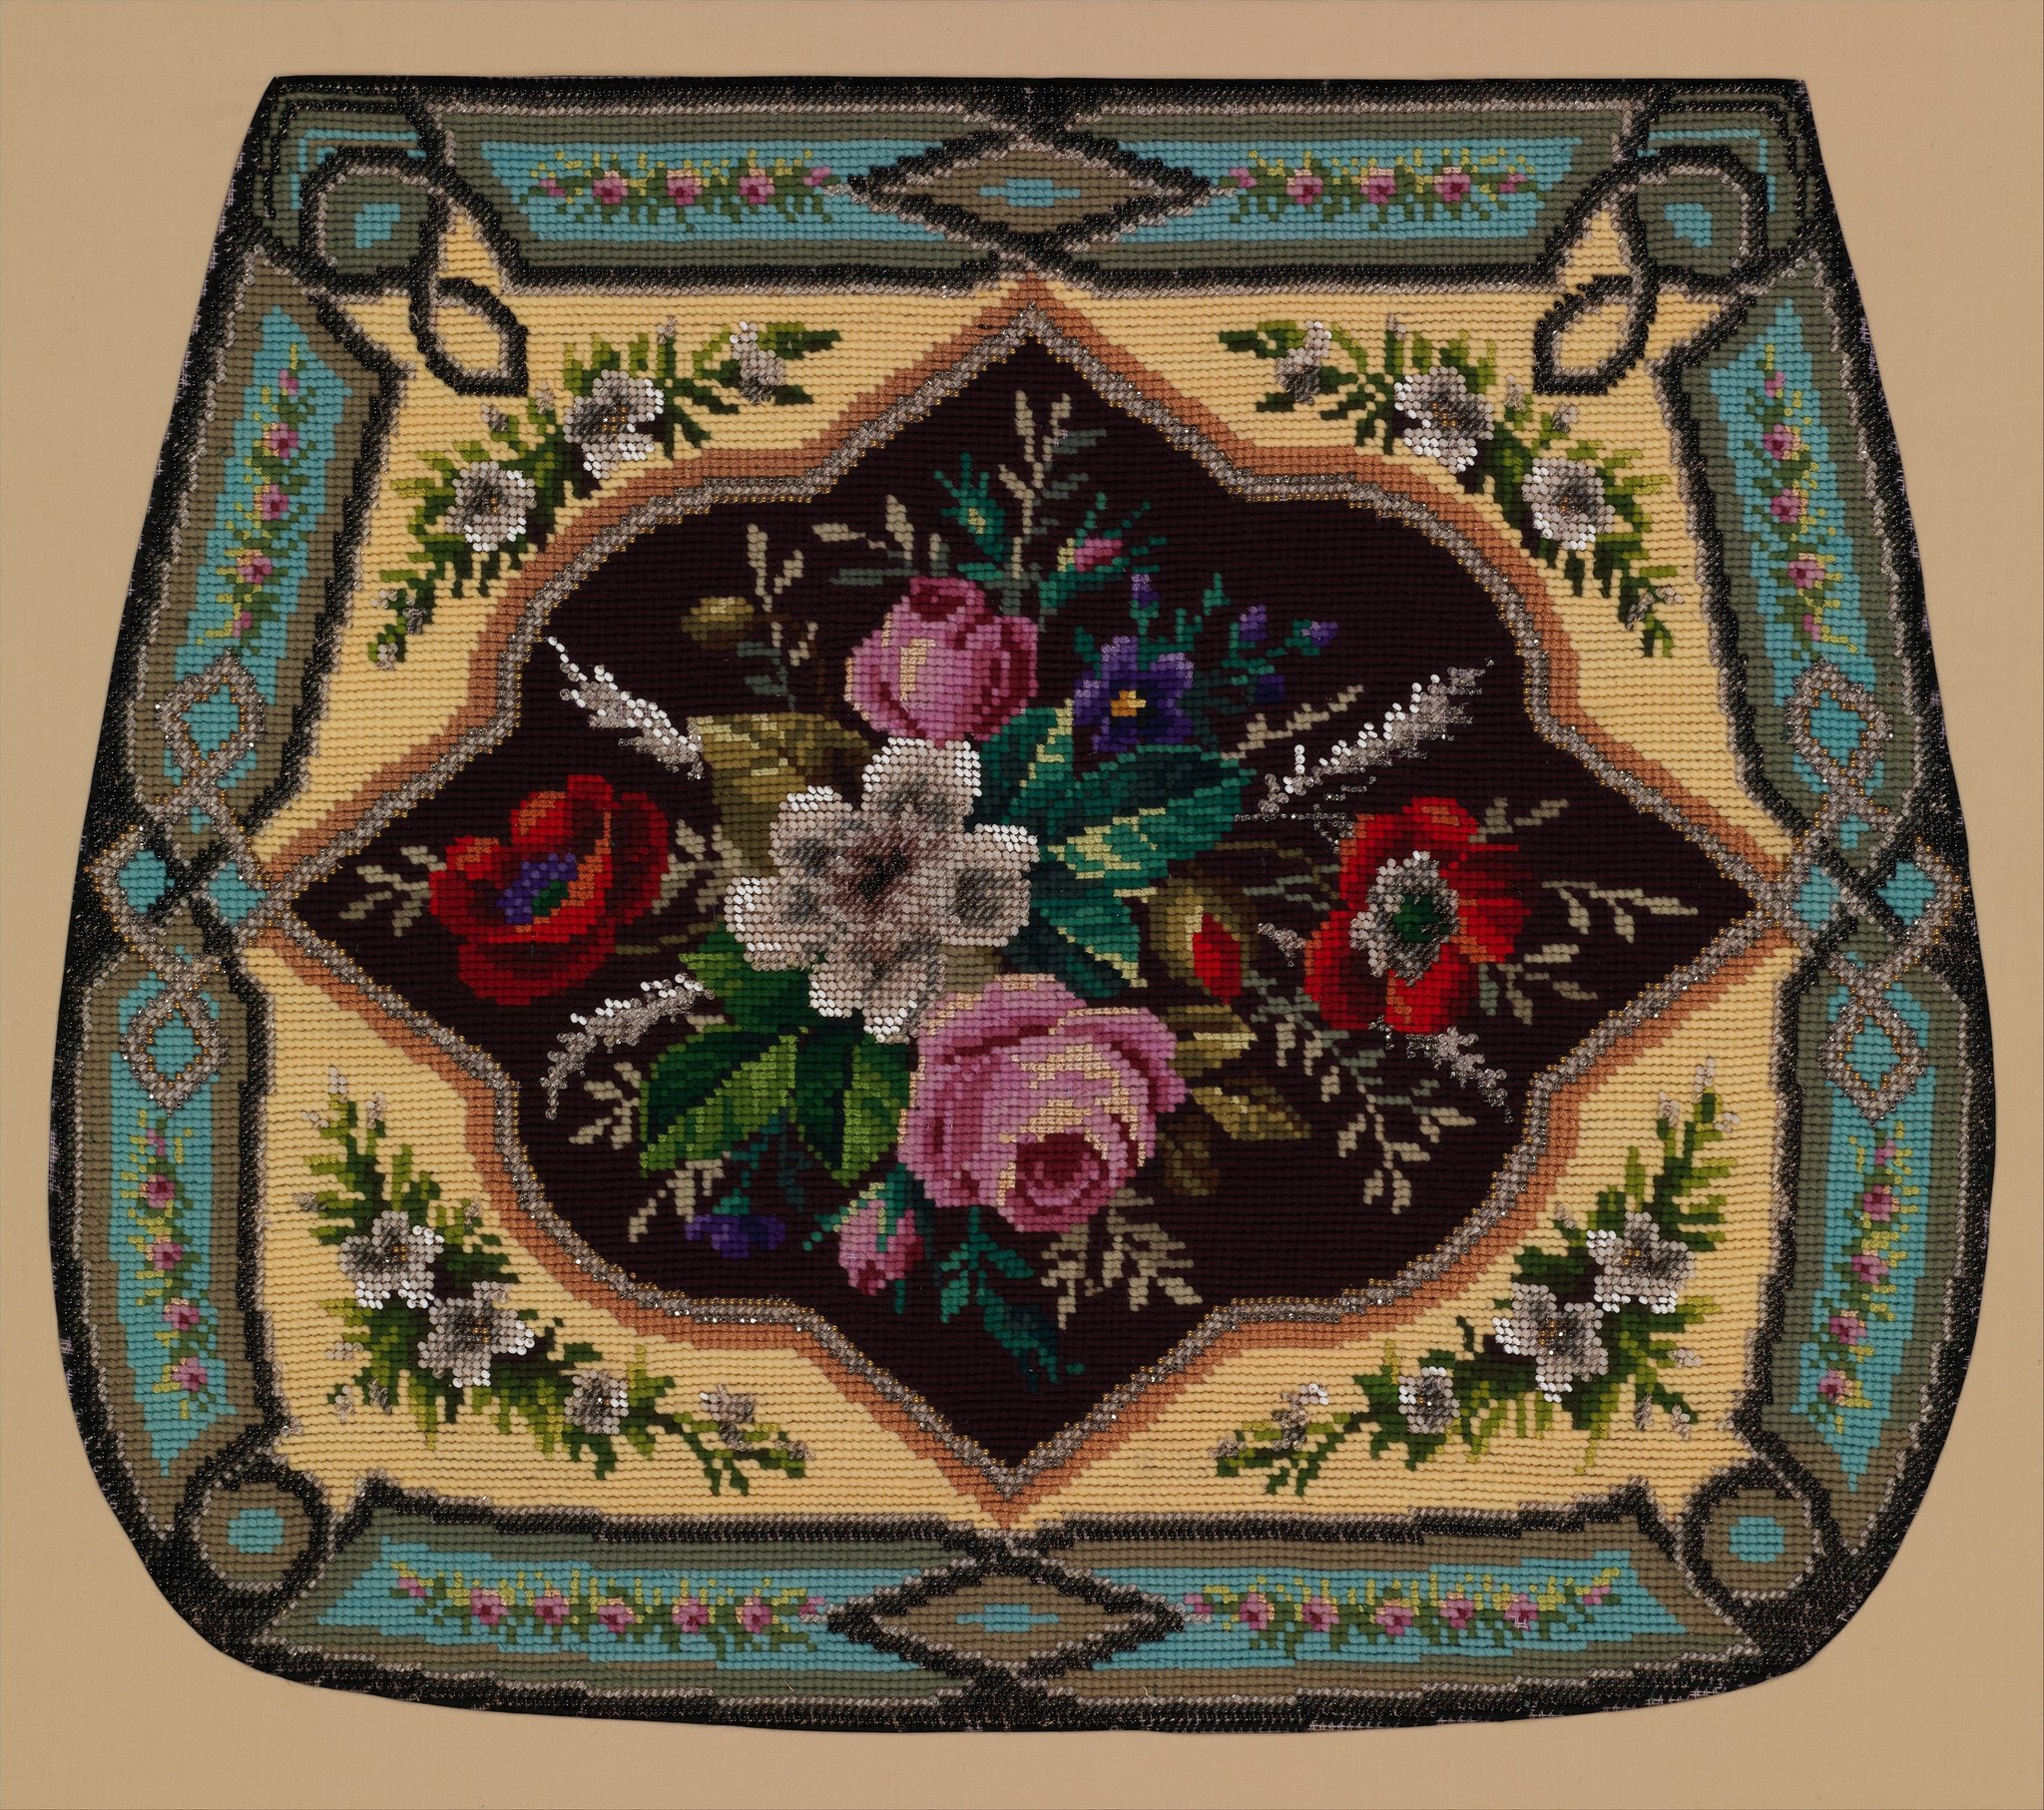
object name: upholstery panel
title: Chair seat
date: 1834-1866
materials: cotton, glass, paste, wool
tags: roses